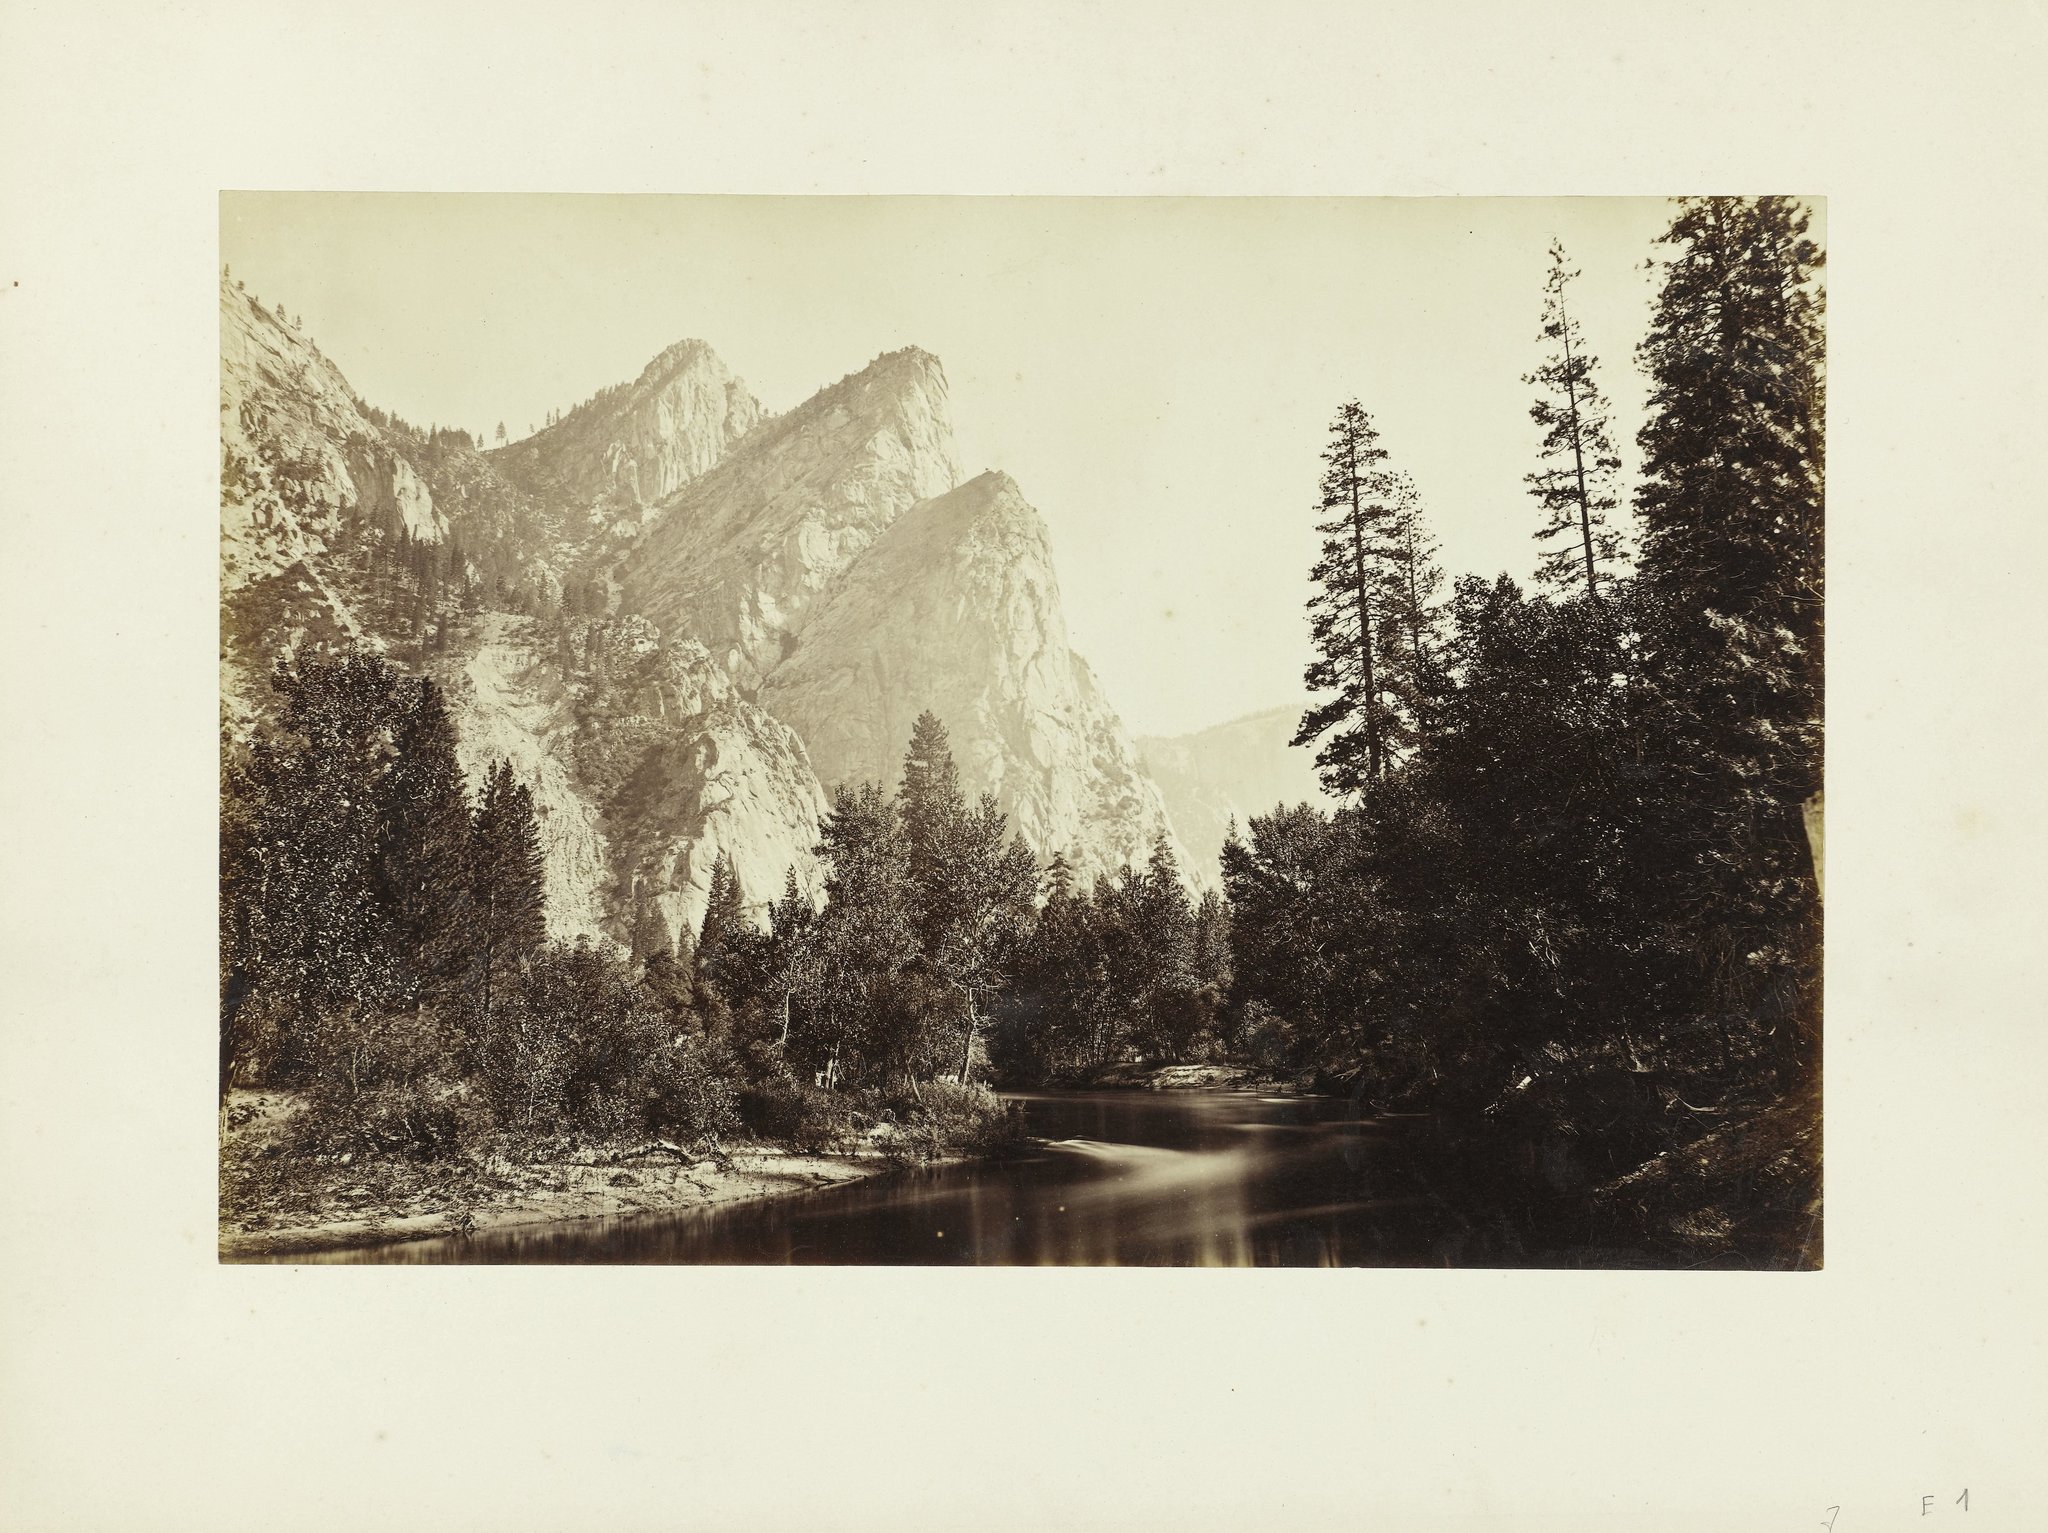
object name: photograph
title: Tibetan man with a yak in the Himalayas, India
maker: frank mason good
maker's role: publisher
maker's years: 1839-1928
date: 1869-1875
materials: paper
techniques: albumen print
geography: himachal pradesh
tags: cattle, mountains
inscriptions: number: ‘4/ 3281’, title: ‘The Yak’